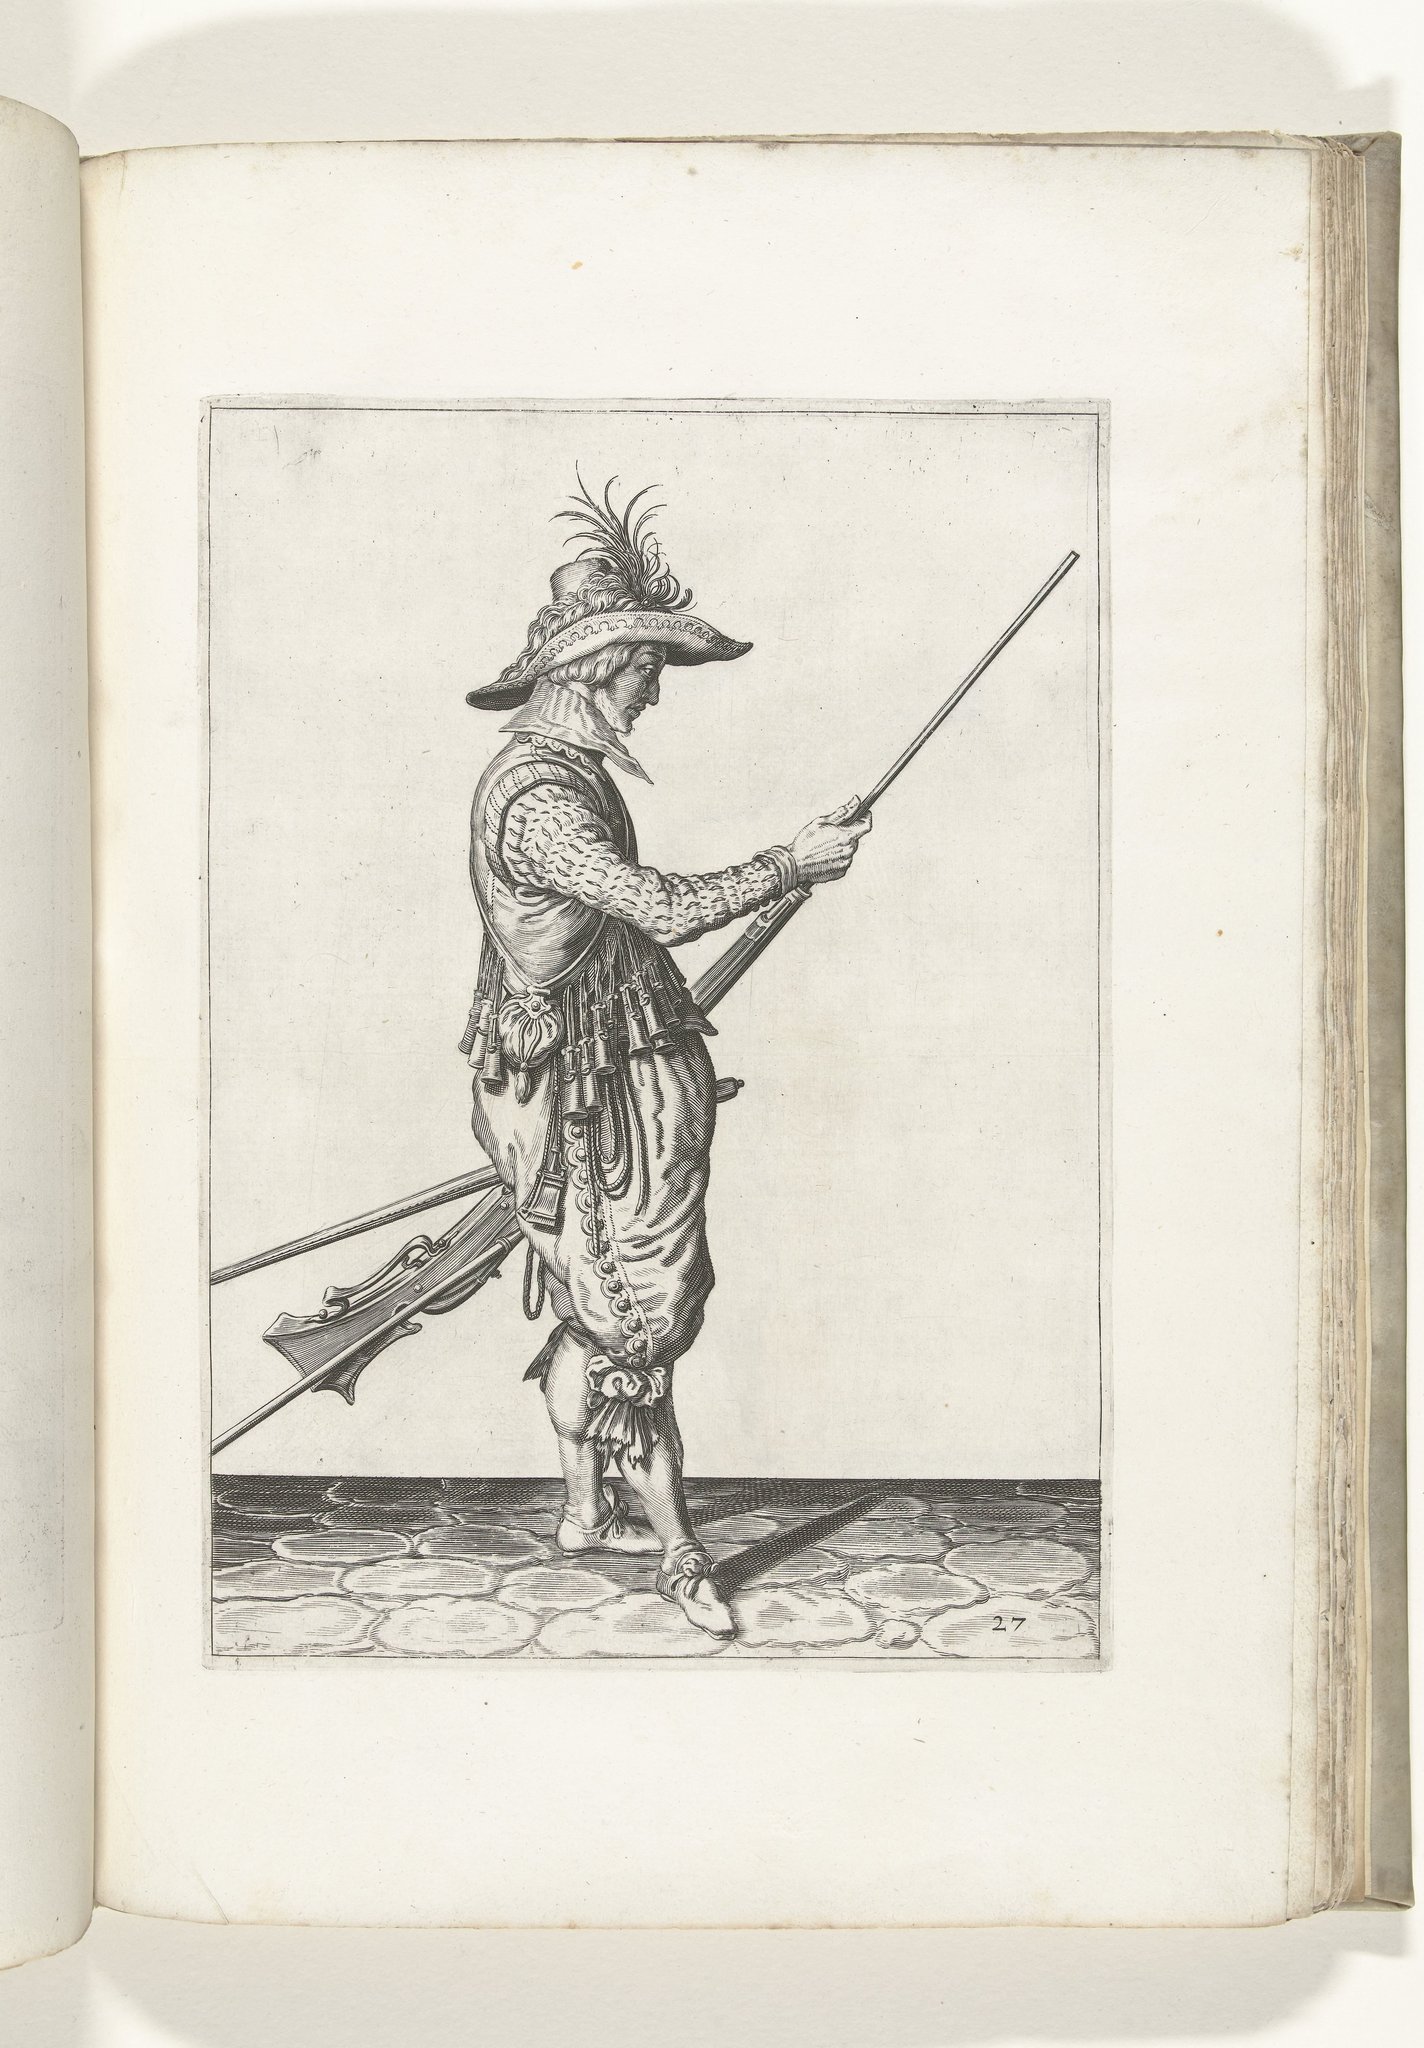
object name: print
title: Soldaat die met zijn laadstok kruit en kogel in de loop van zijn musket duwt (nr. 27), ca. 1600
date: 1597-1607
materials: paper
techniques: engraving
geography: the hague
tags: the hague, maurice (prince of orange), handling of weapons ~ military training, weapons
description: Een soldaat, ten voeten uit, naar rechts, die met zijn linkerhand bij zijn linkerdijbeen een musket (een bepaald type vuurwapen) vasthoudt en met zijn rechterhand zijn laadstok in de loop brengt, om kruit en kogel aan te duwen (nr. 27), ca. 1600. In zijn linkerhand behalve het musket ook een furket (musketvork) en een lont. Plaat 27 in de instructies voor het hanteren van het musket: Corte onderrechtinghe op de figuerliicke afbeeldinghe, soo veel aengaet het recht ghebruyck vant Musquet. Onderdeel van de illustraties in: J. de Gheyn, Wapenhandelinghe van Roers Musquetten ende spiessen, 's-Gravenhage, 1607. Krijgswezen rond 1600.